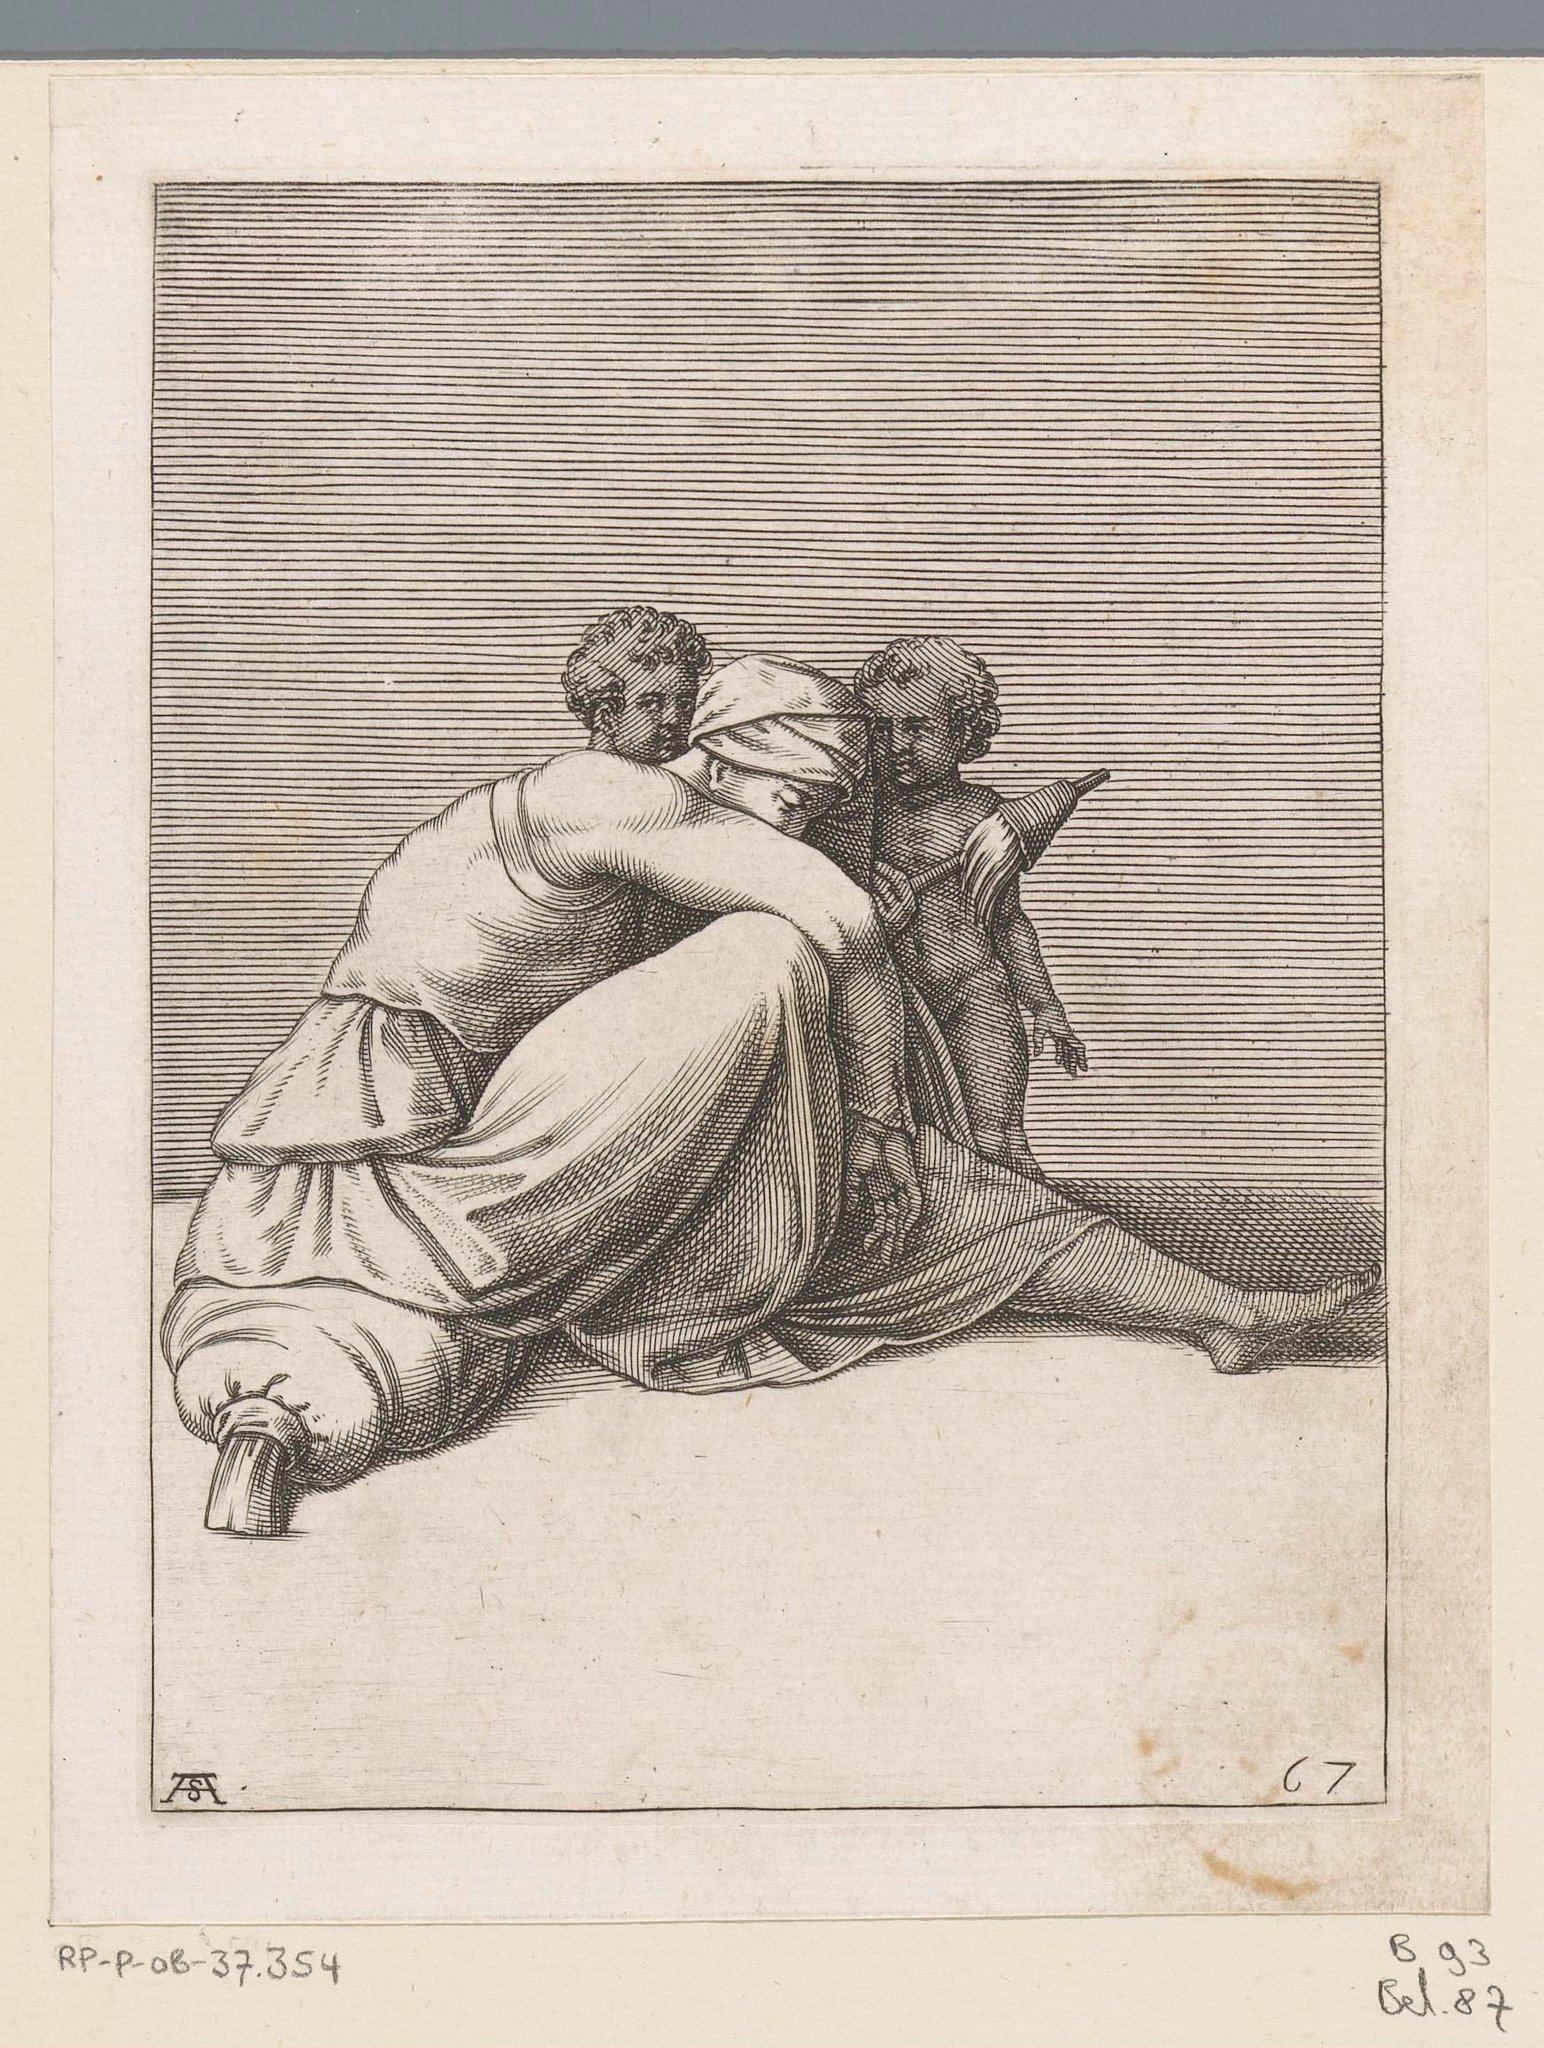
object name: print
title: Vrouw met een spinrokken en twee kinderen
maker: adamo scultori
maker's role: painter, print maker, sculptor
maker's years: 1530-1585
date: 1585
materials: paper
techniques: engraving, intaglio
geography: vatican city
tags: distaff, mother and child(ren), woman and child(ren) (family group)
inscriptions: collector's mark: Lugt 240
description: Deze prent maakt deel uit van een serie bestaande uit een titelprent en 72 prenten naar schilderingen door Michelangelo in de Sixtijnse Kapel in het Vaticaan.